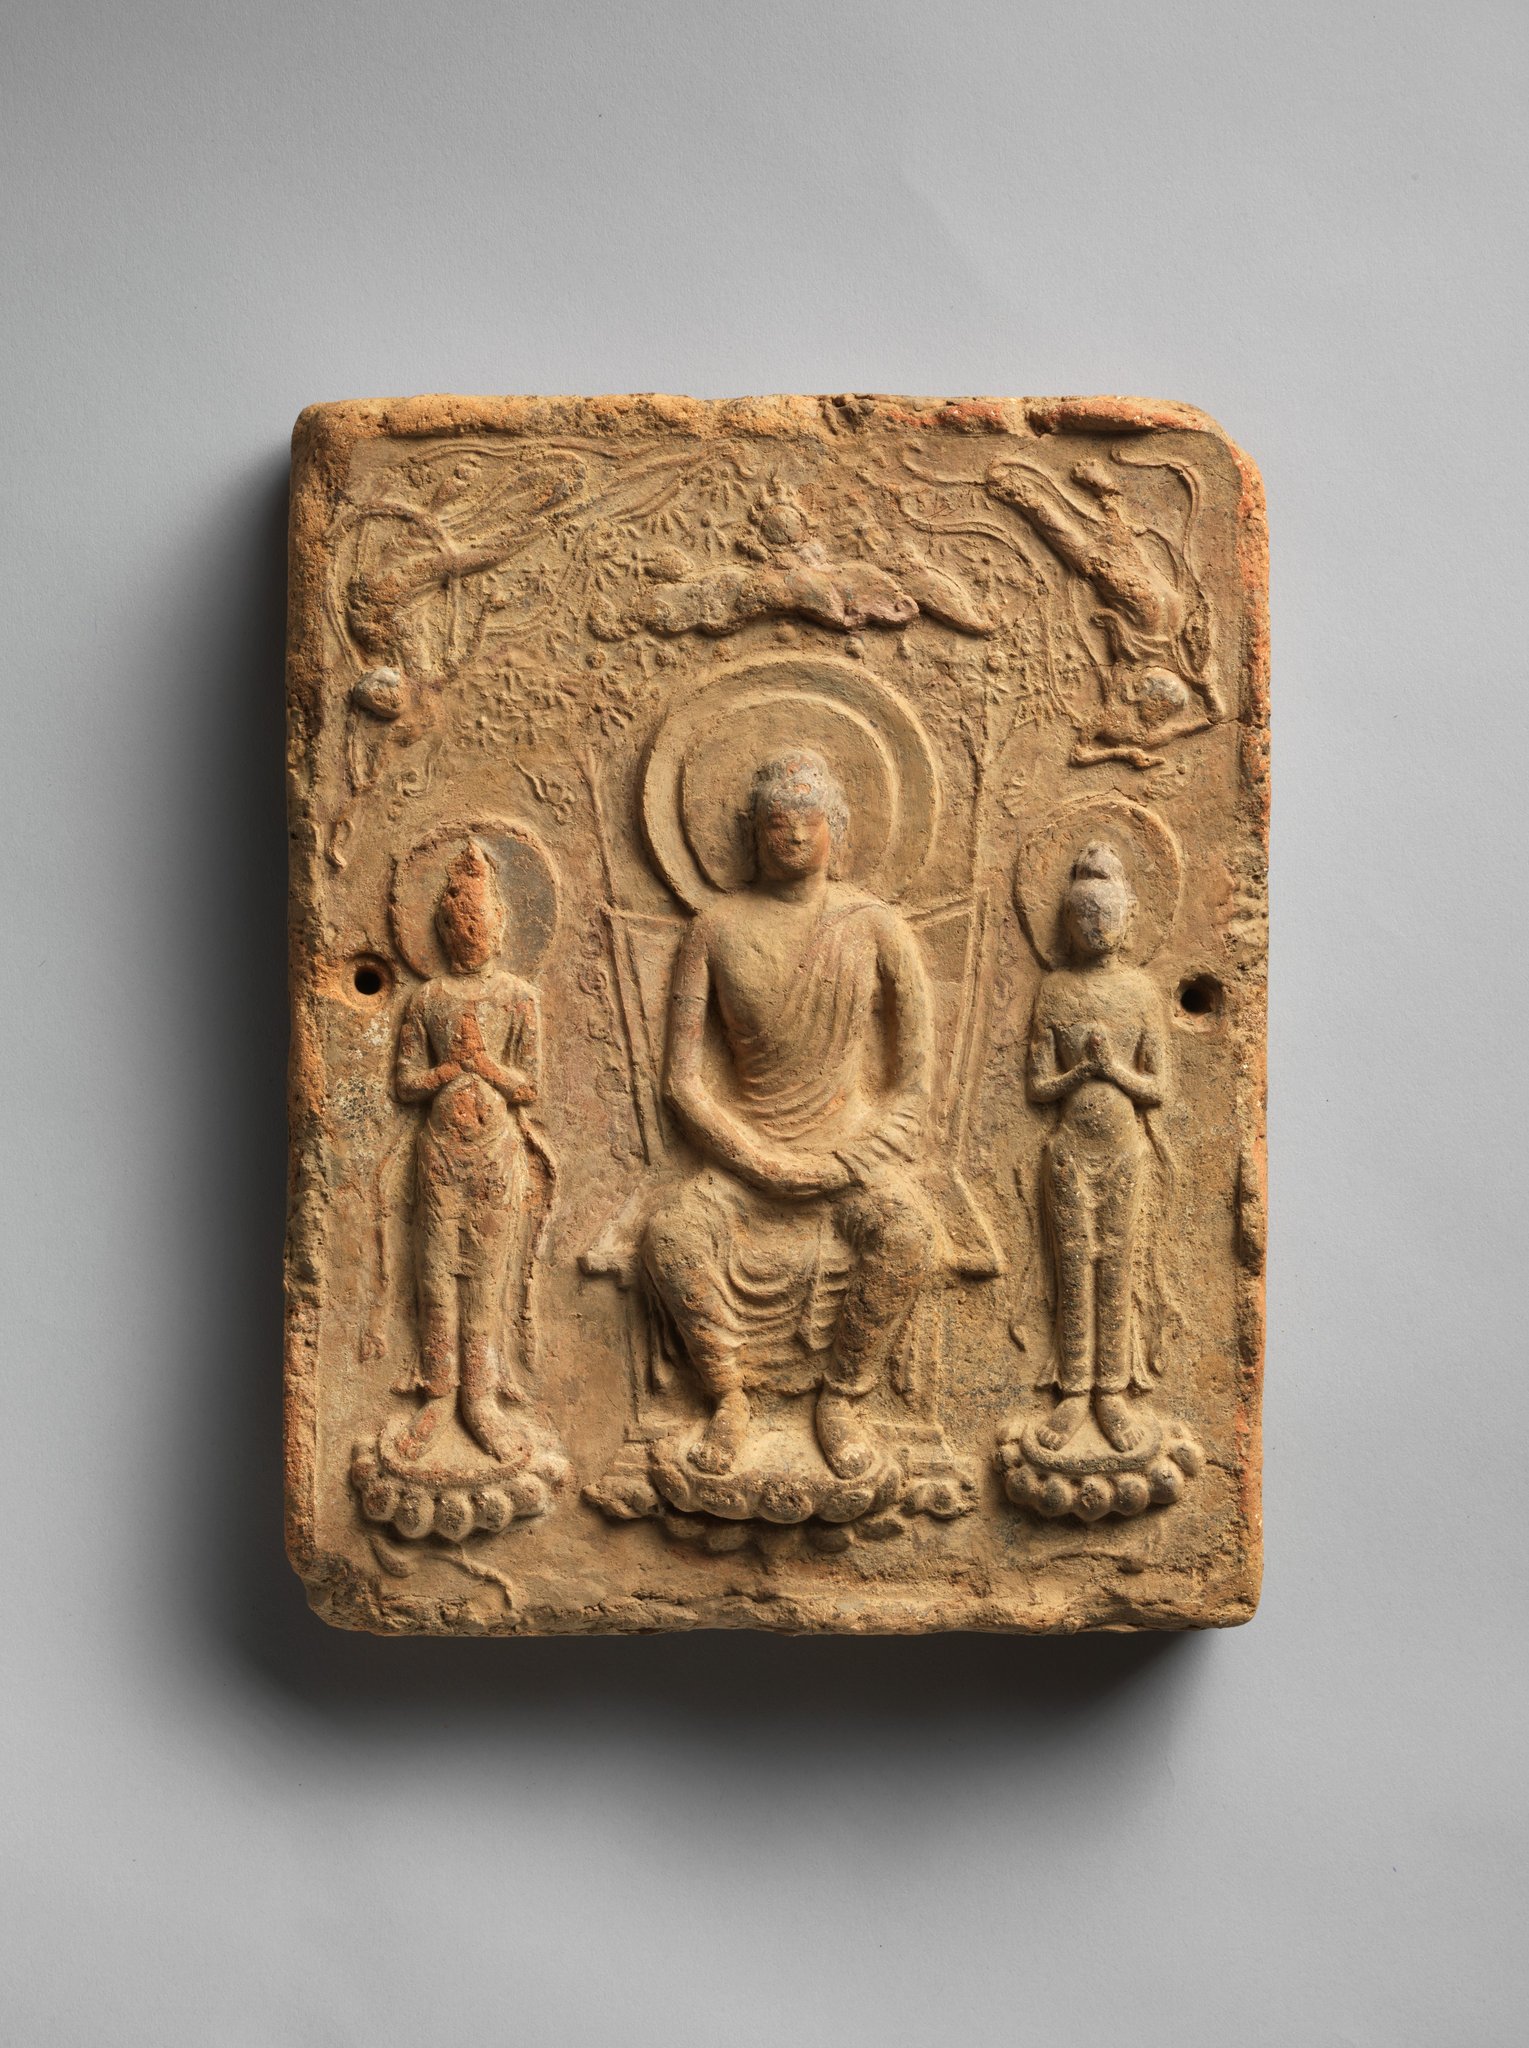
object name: relief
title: Tile with Buddha Triad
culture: japanese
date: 651-700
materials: earthenware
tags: buddhism,bodhisattvas,buddha